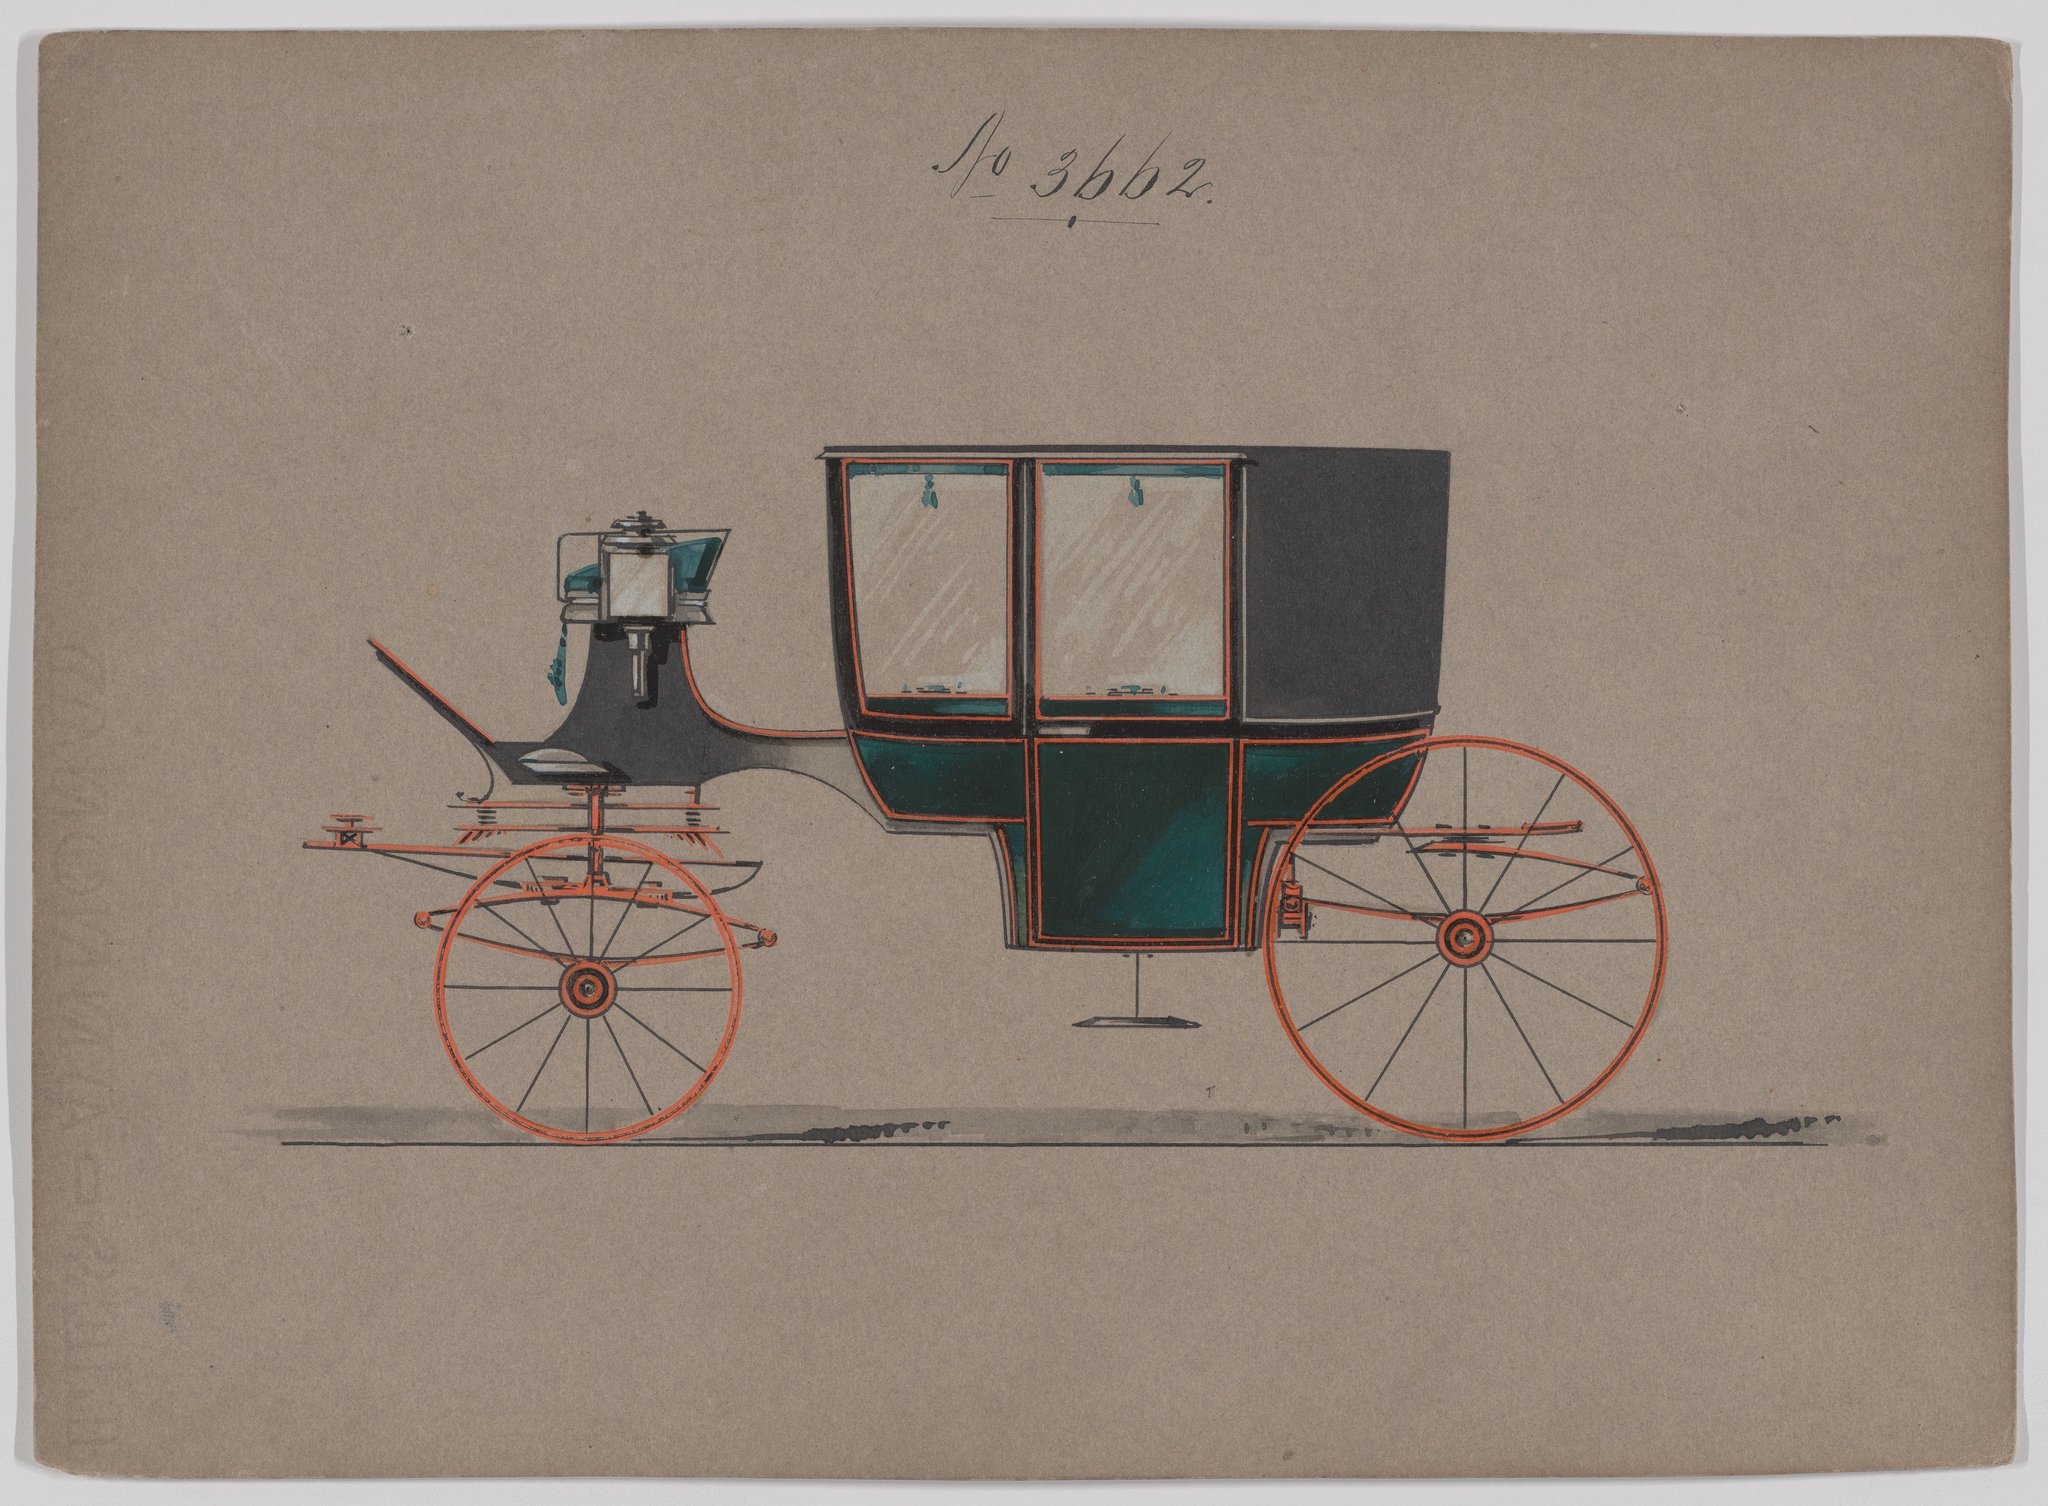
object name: drawing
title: Coach #3662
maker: brewster & co.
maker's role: manufacturer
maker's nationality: american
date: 1881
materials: gouache, gum arabic, ink, watercolor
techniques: pen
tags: carriages